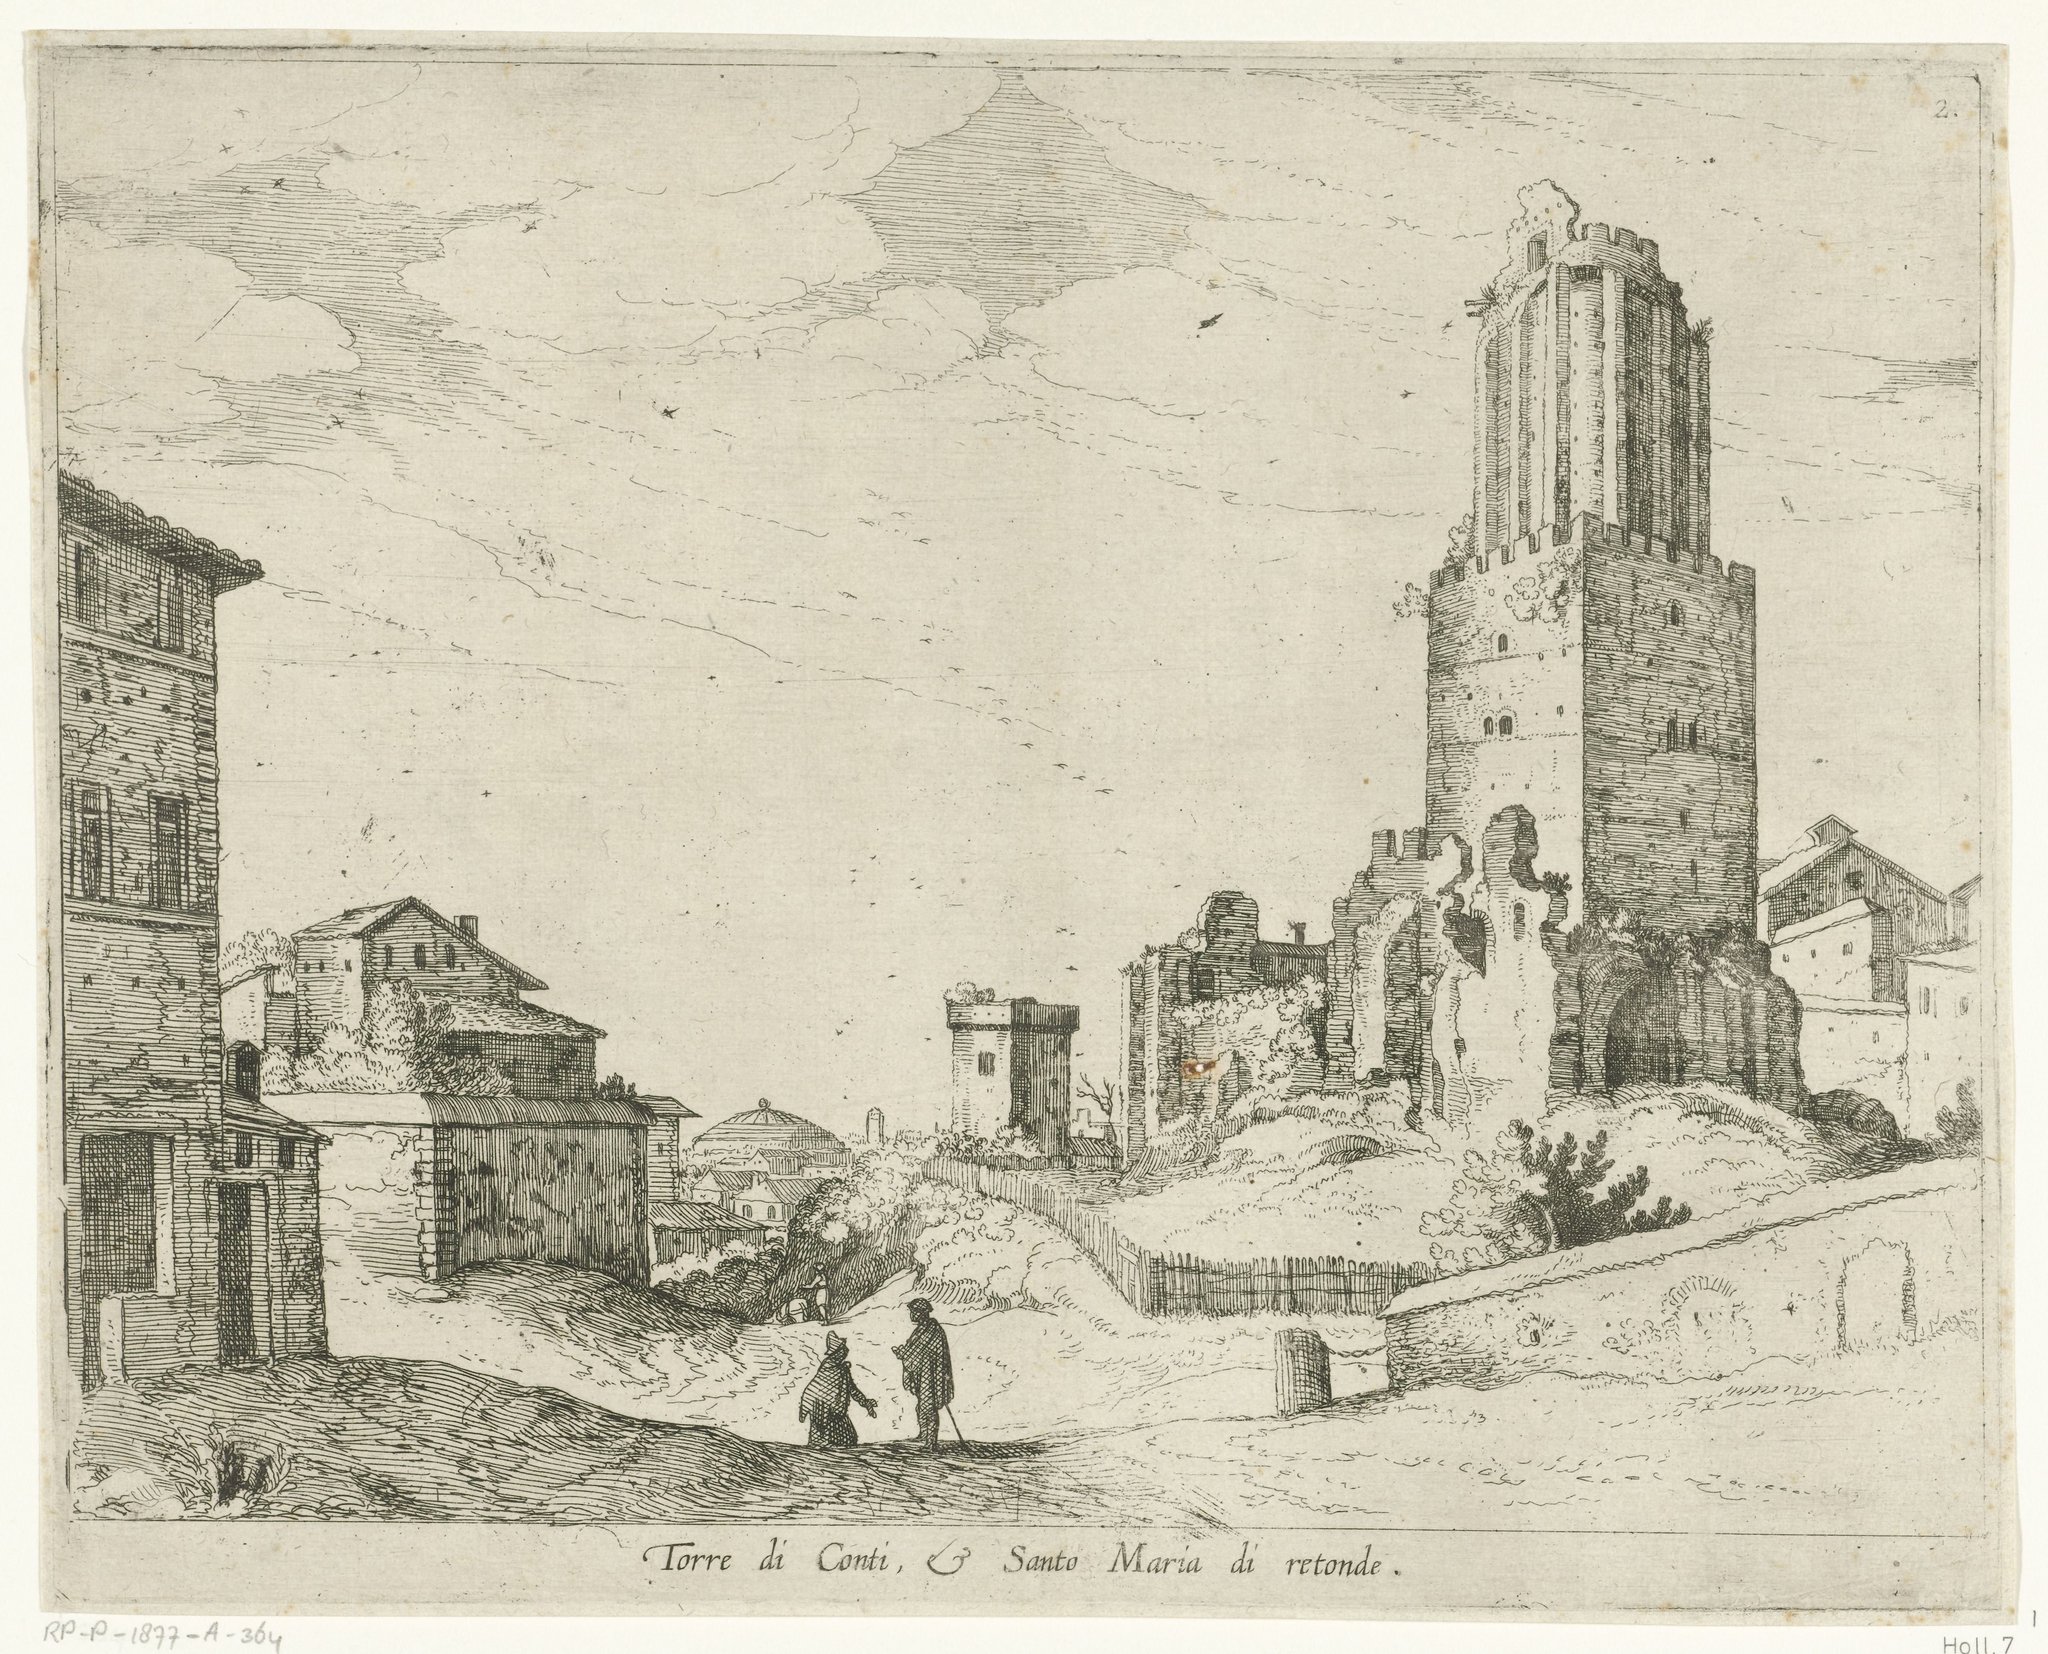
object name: print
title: Torre di Conti e Santo Maria di retonde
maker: guilliam van nieulandt (ii)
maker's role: draughtsman, print maker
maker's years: 1584-1635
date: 1594-1635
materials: paper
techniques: etching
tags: landscape with tower or castle (+ city(-scape) with figures, staffage), rome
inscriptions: collector's mark: Lugt 2228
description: Rechts de Torre delle Milizie, een toren in Rome. Op de achtergrond is de koepel van het Pantheon zichtbaar. Op de voorgrond twee figuren, die met elkaar in gesprek zijn.